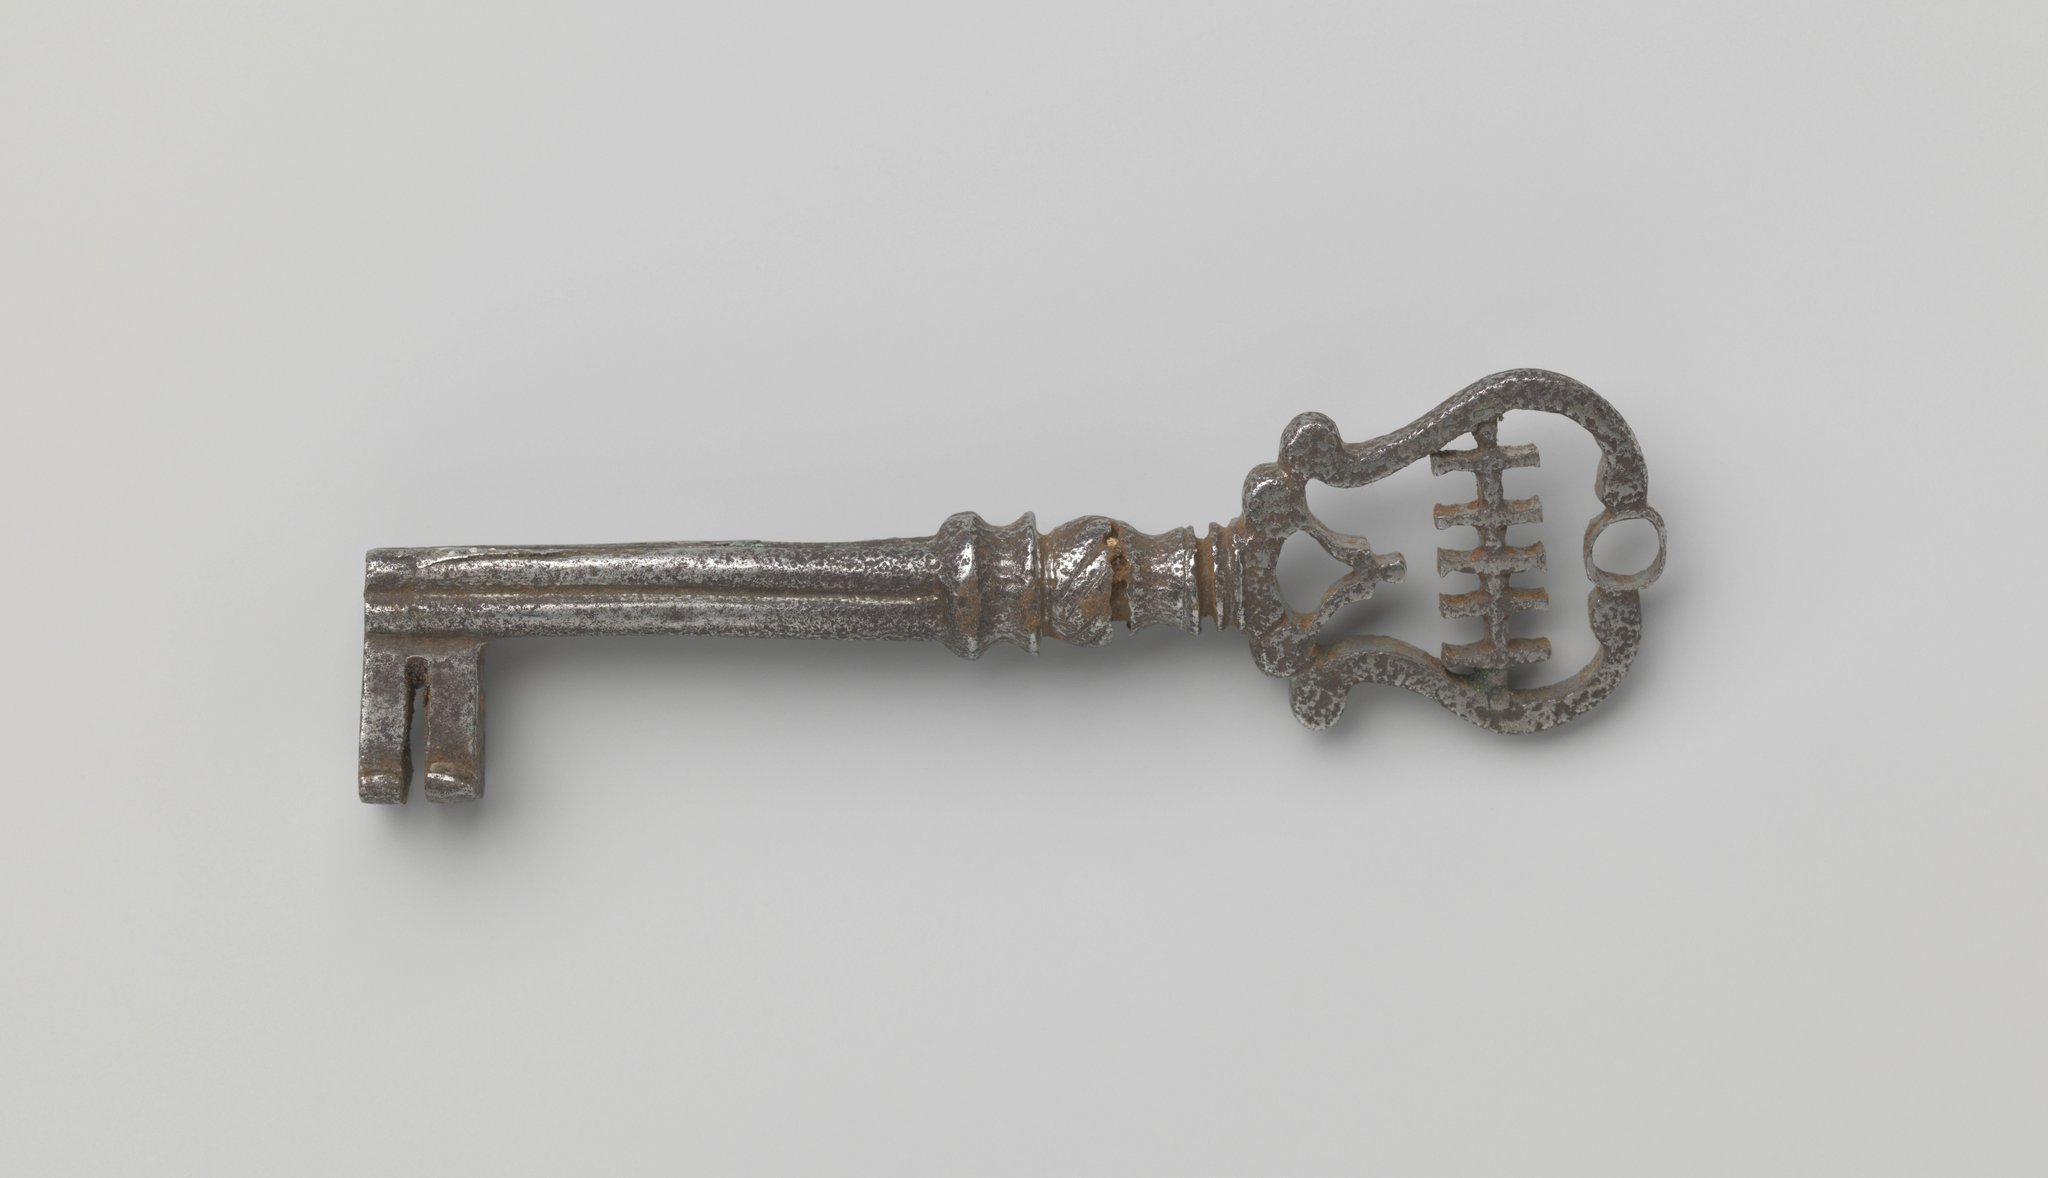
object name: key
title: Sleutel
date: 1700-1725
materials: iron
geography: germany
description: IJzeren sleutel met gesmeed doorgewerkt oog.